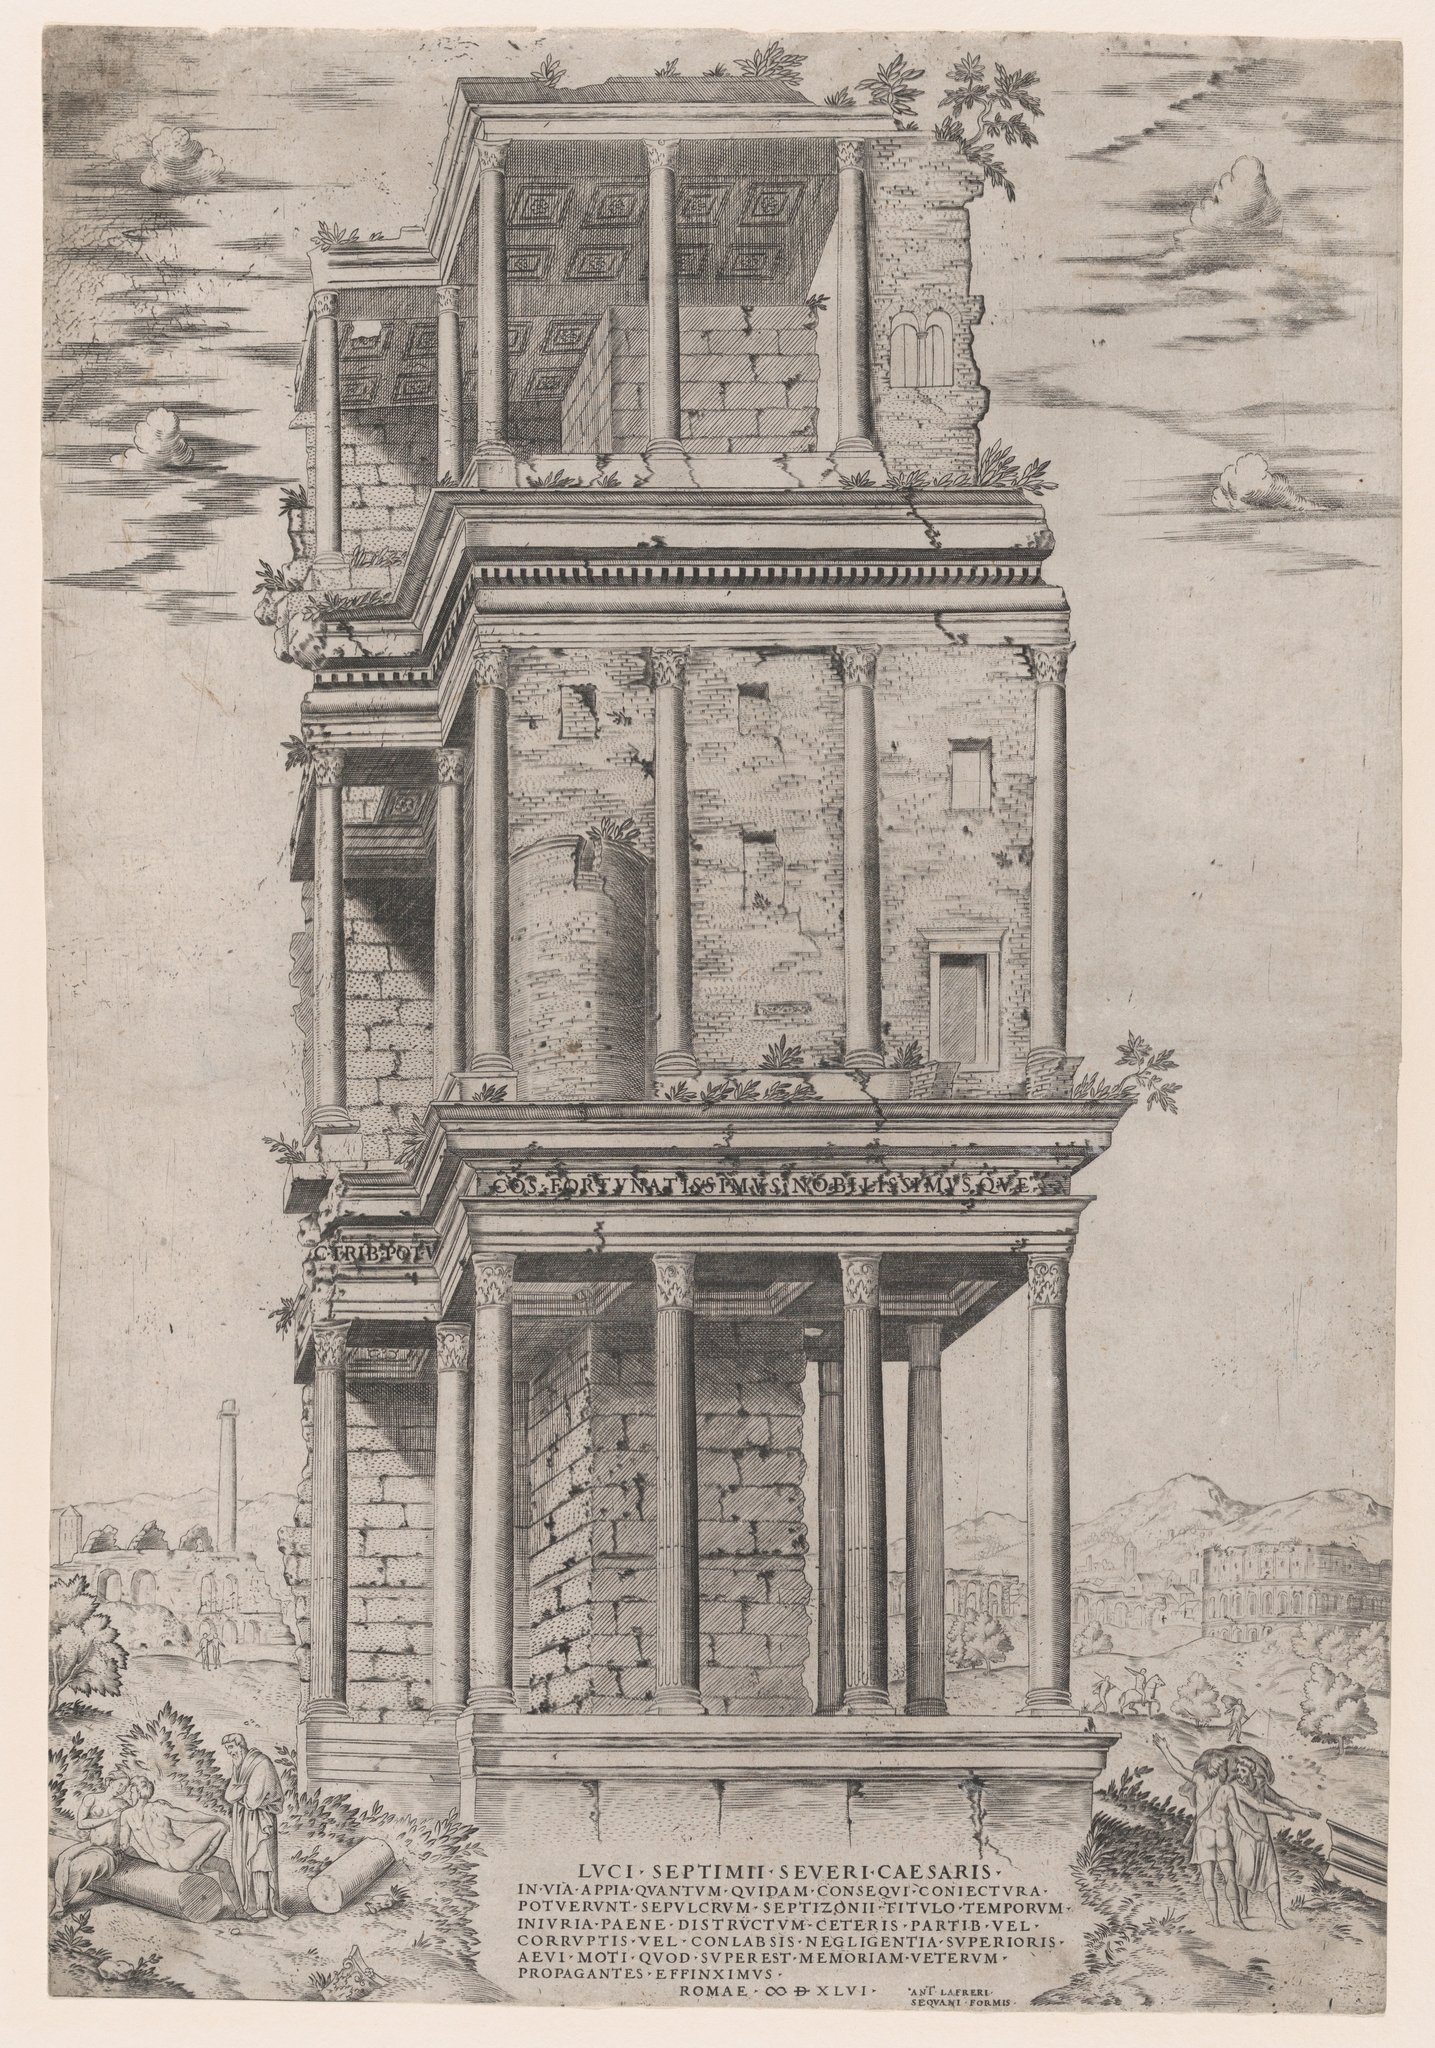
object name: print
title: The Septizodium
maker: Anonymous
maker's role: artist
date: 1556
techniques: engraving, etching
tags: buildings